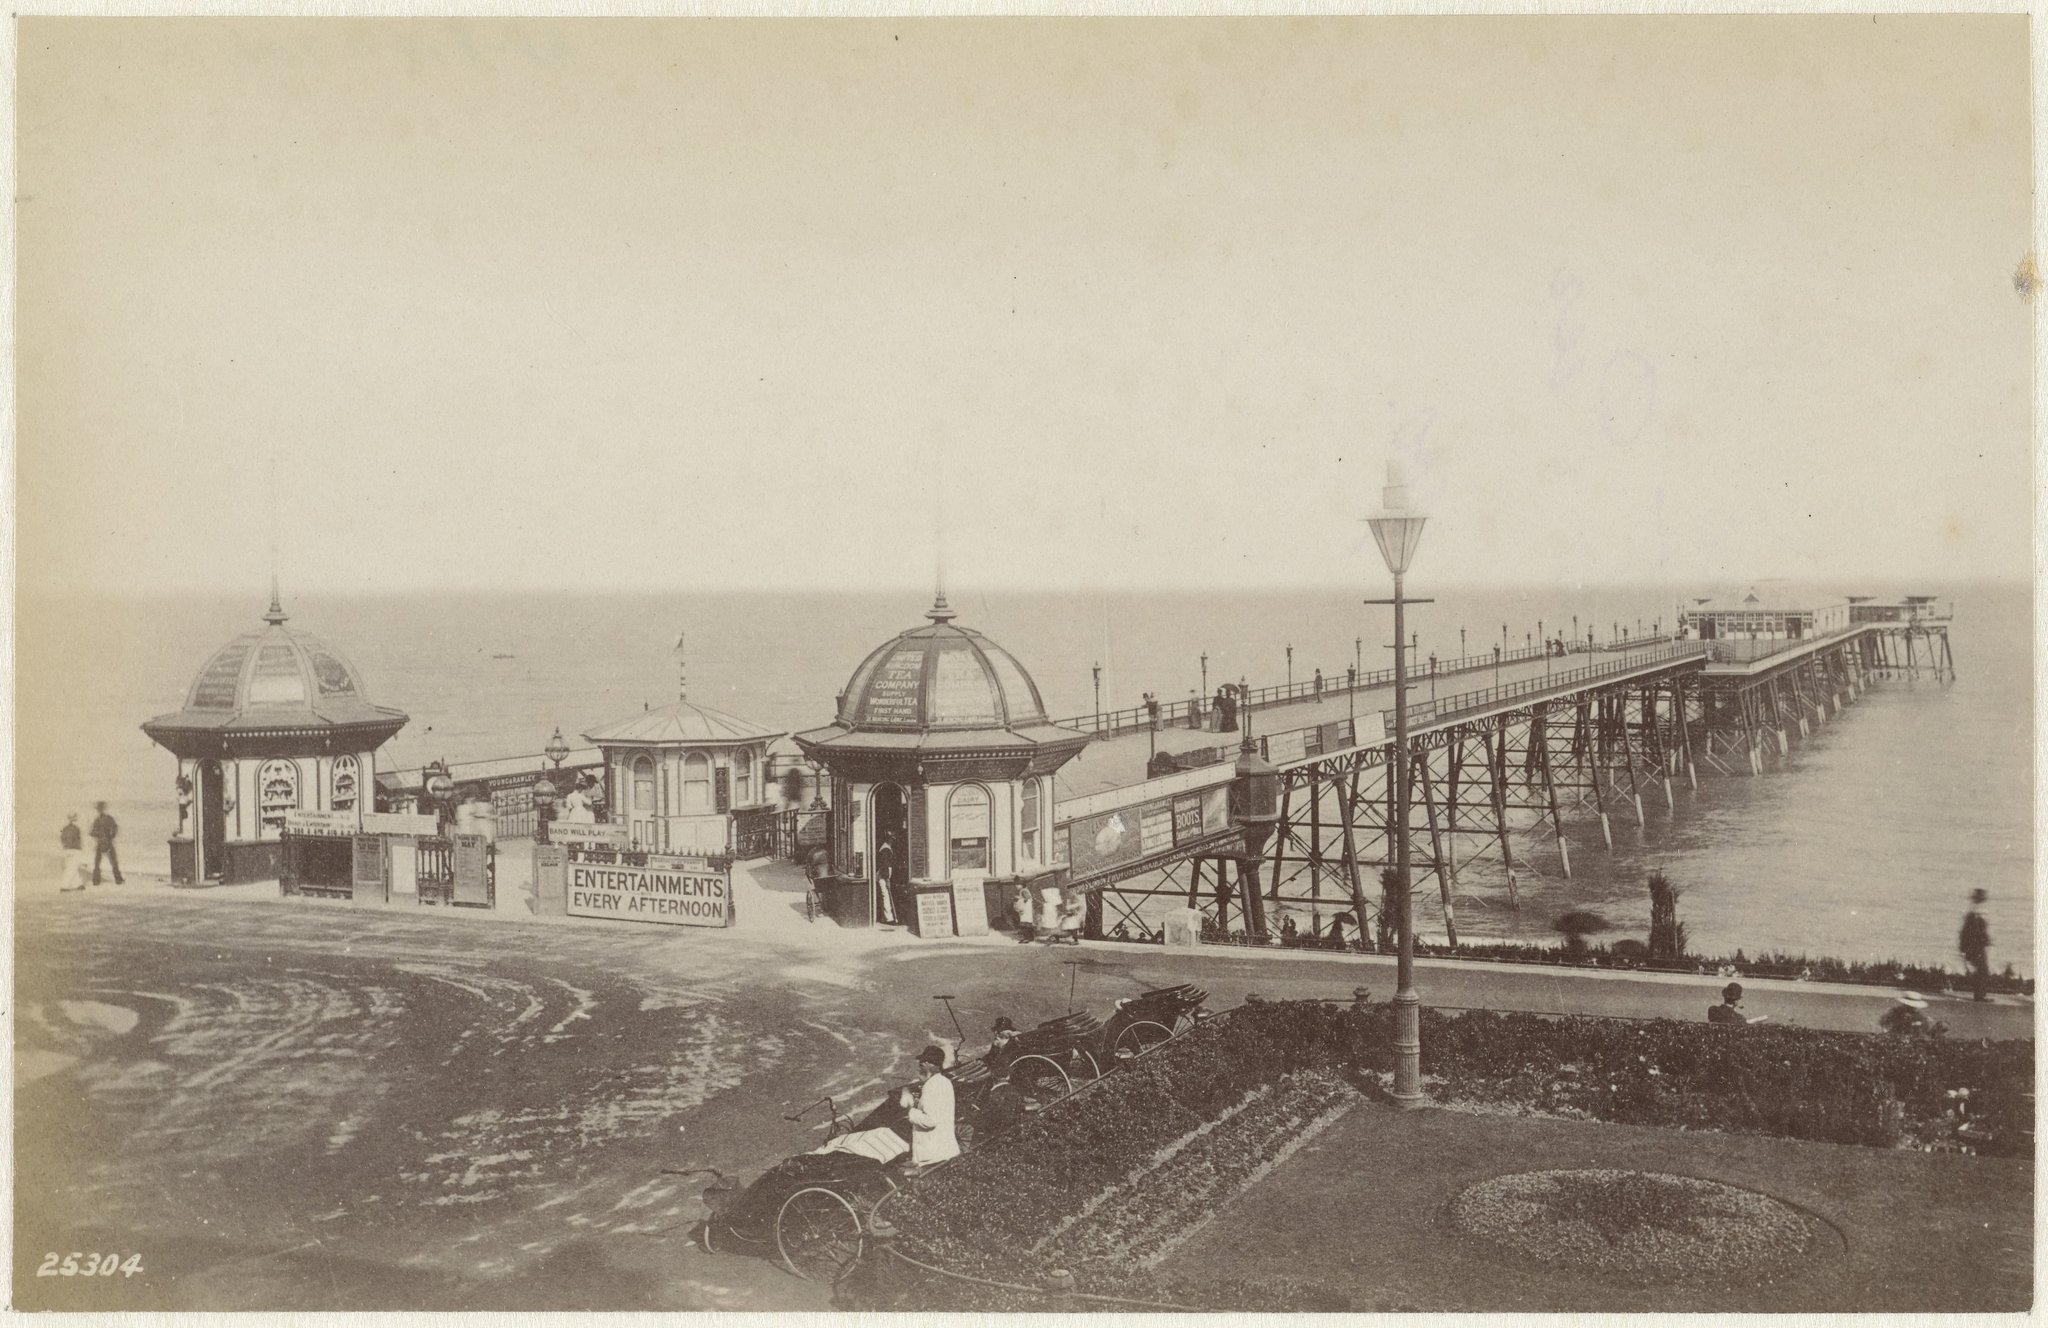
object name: photograph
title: Gezicht op de pier van Eastbourne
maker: Anonymous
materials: paper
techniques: albumen print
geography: eastbourne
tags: pier, quay, wharf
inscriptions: number: ‘25304’, inscription: ‘Eastbourne view/ Eastbourne/ The Pier/ 14-16/4 1900.’